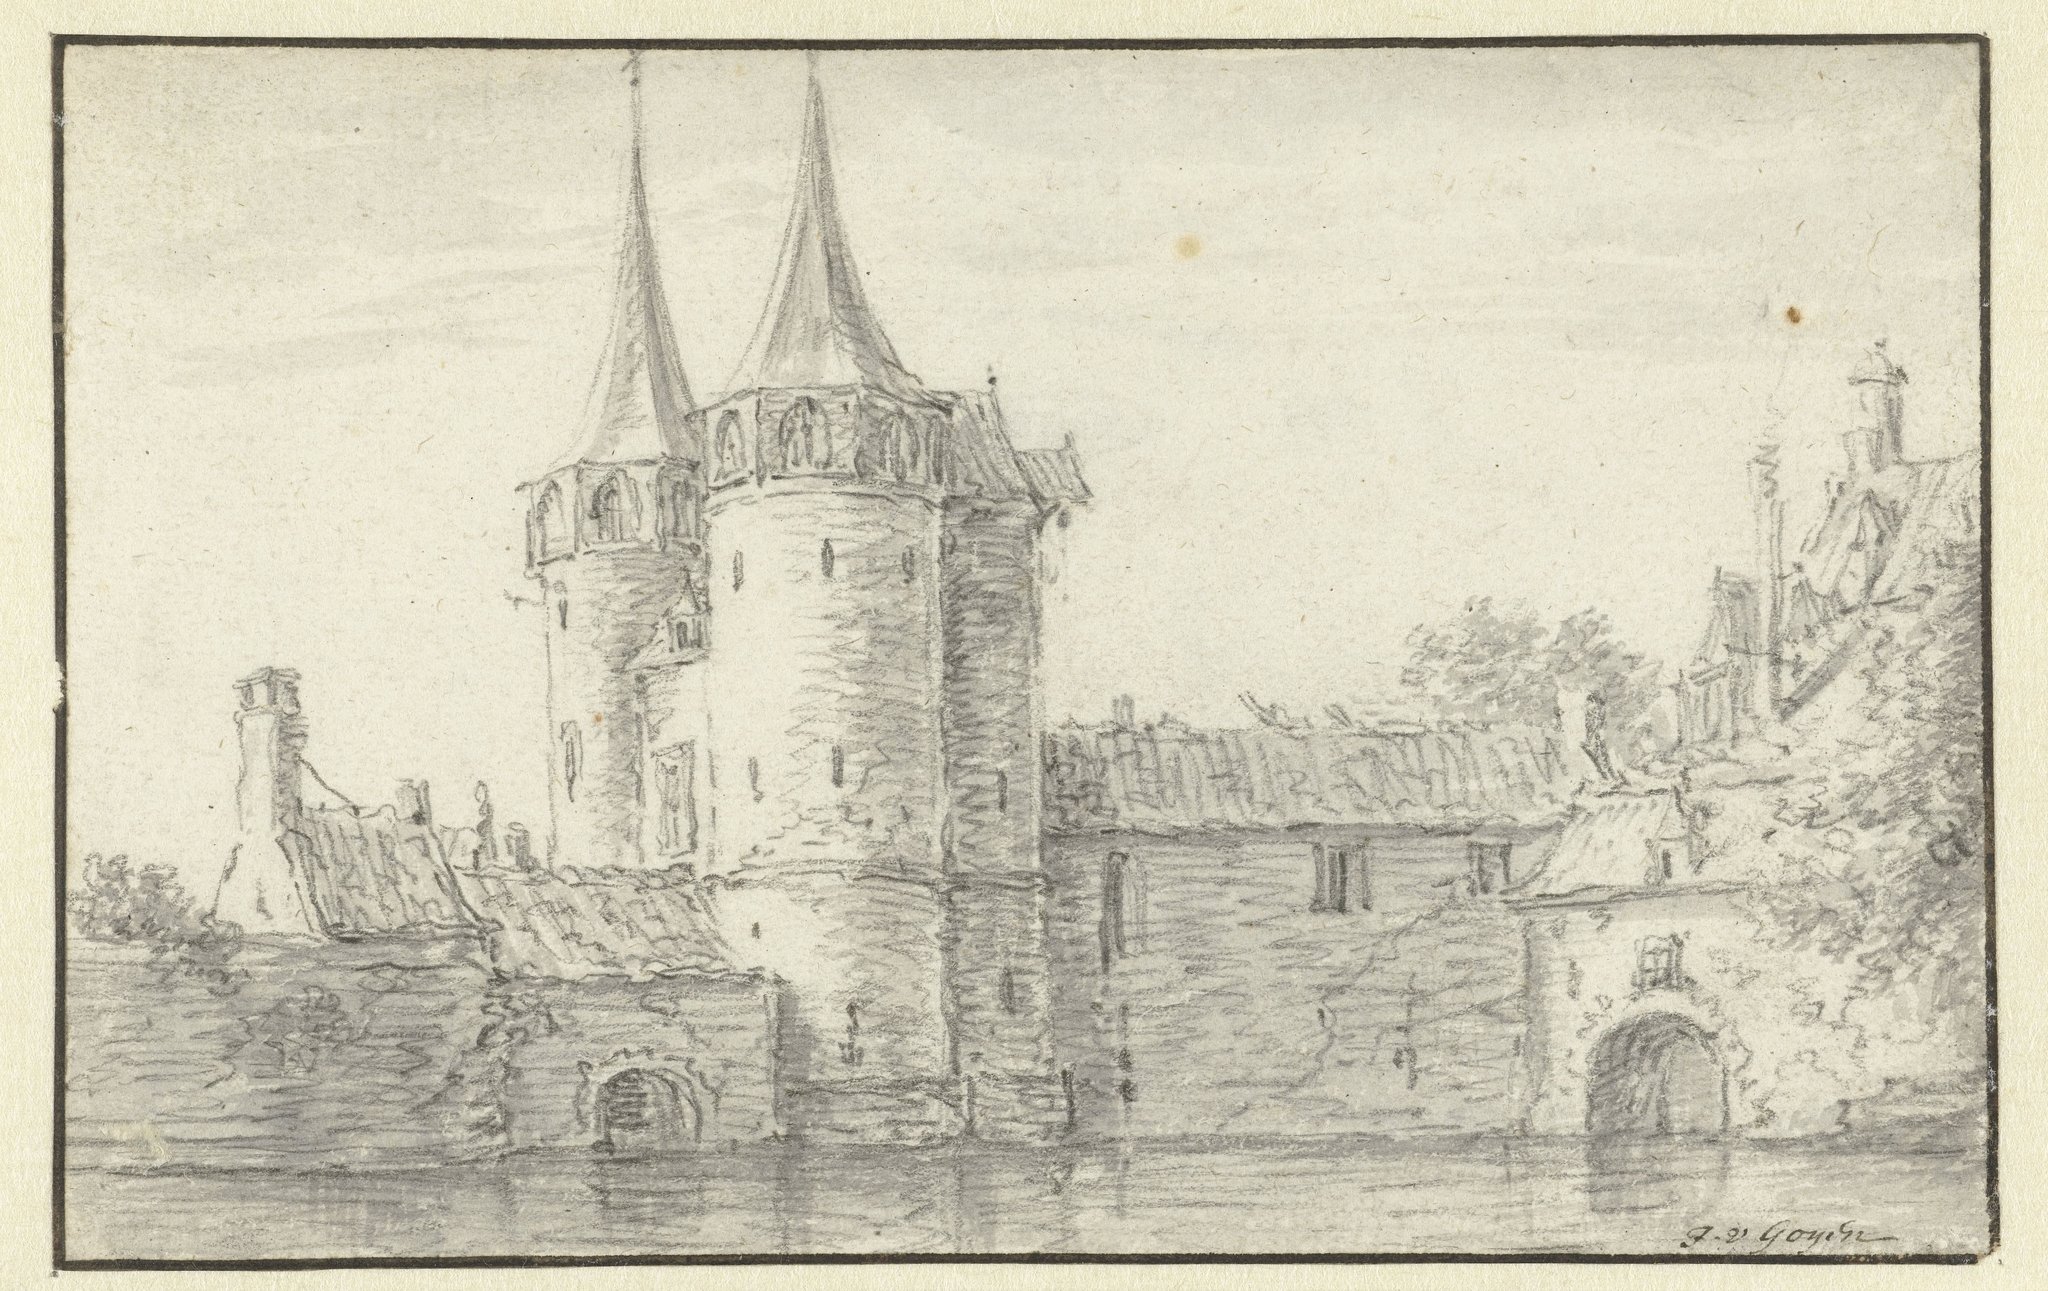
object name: drawing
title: Oostpoort in Delft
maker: jan van goyen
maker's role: draughtsman, painter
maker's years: 1596-1656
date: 1606-1656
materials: chalk, paper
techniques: brush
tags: city-gate, delft